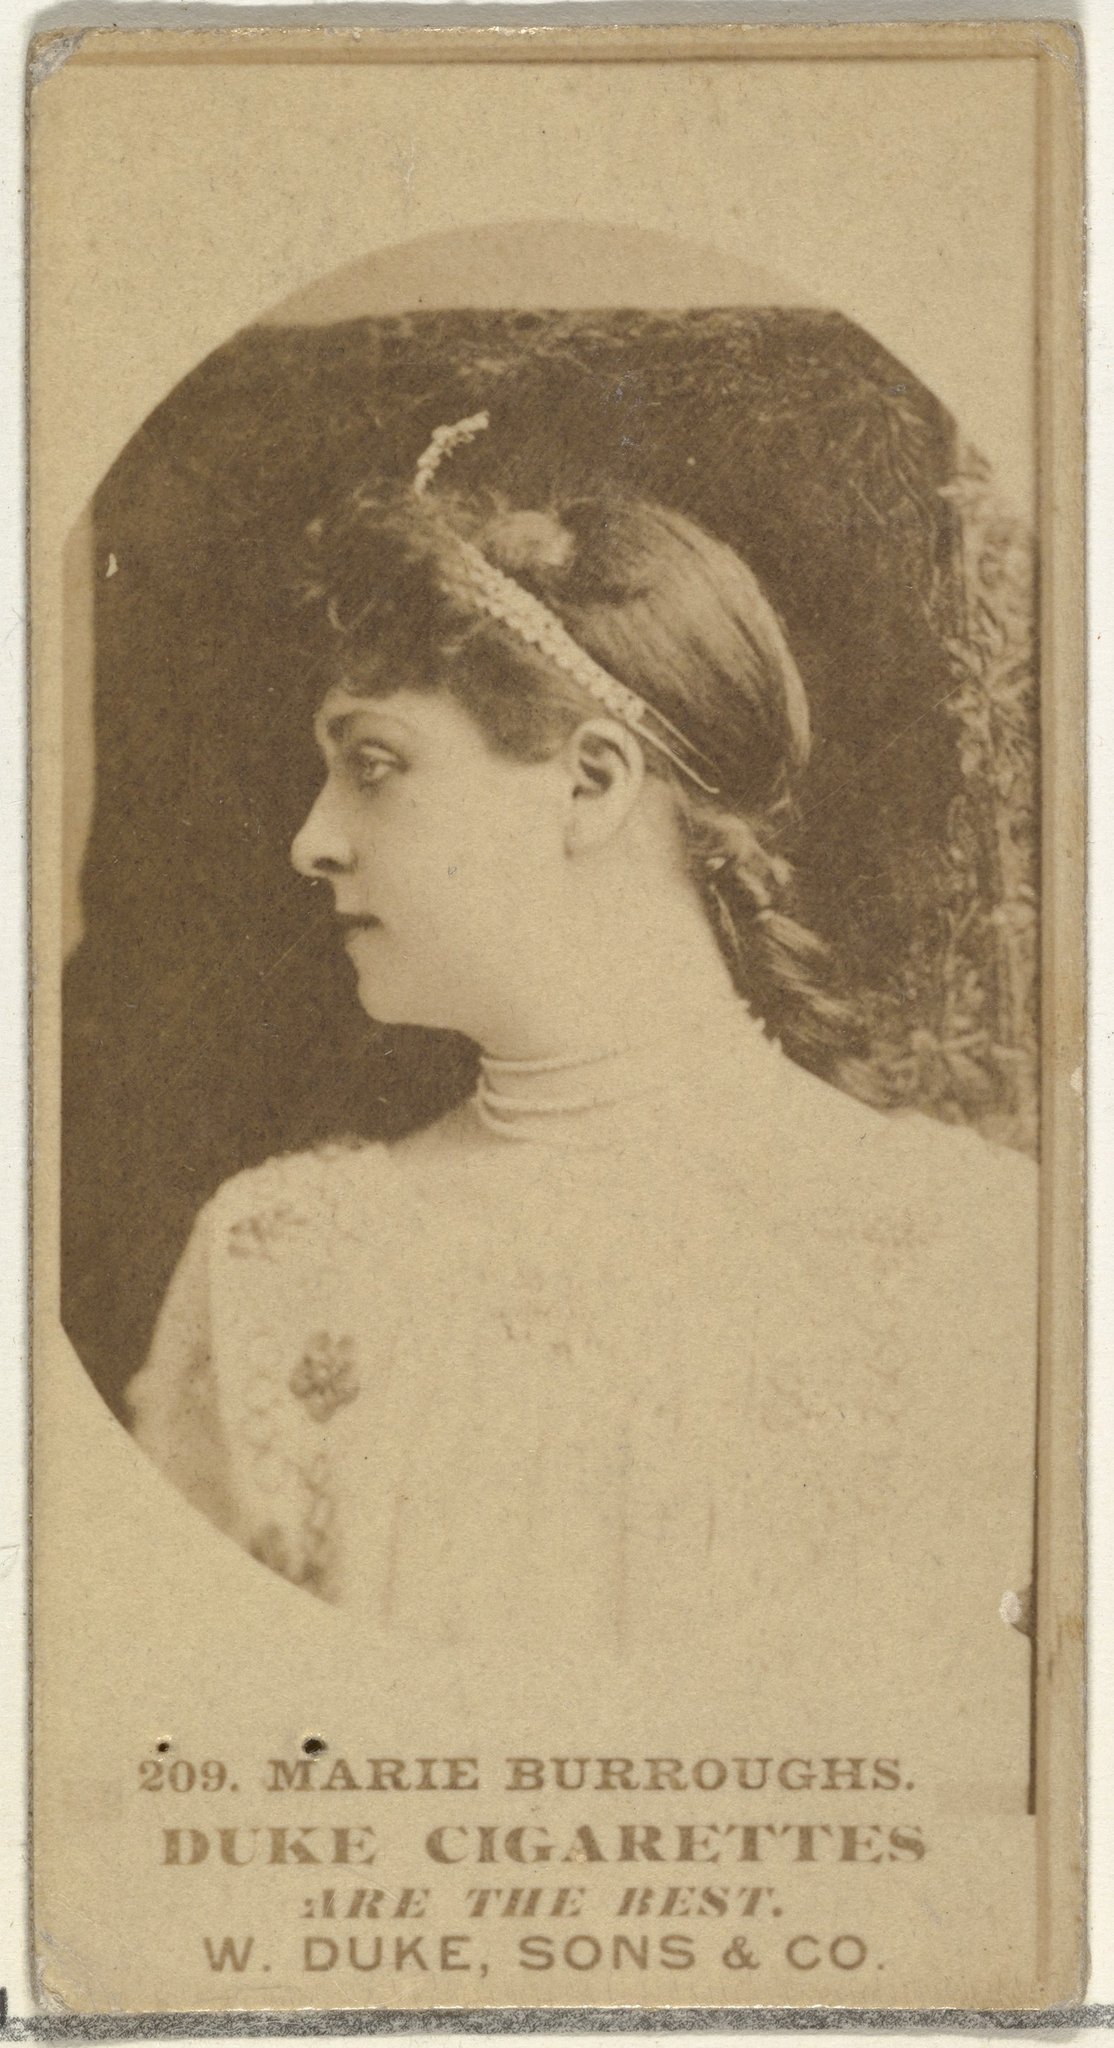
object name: photograph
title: Card Number 209, Marie Burroughs, from the Actors and Actresses series (N145-7) issued by Duke Sons & Co. to promote Duke Cigarettes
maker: w. duke, sons & co.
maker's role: publisher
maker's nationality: american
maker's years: 1870-1920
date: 1880-1889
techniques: albumen silver print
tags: women,actresses